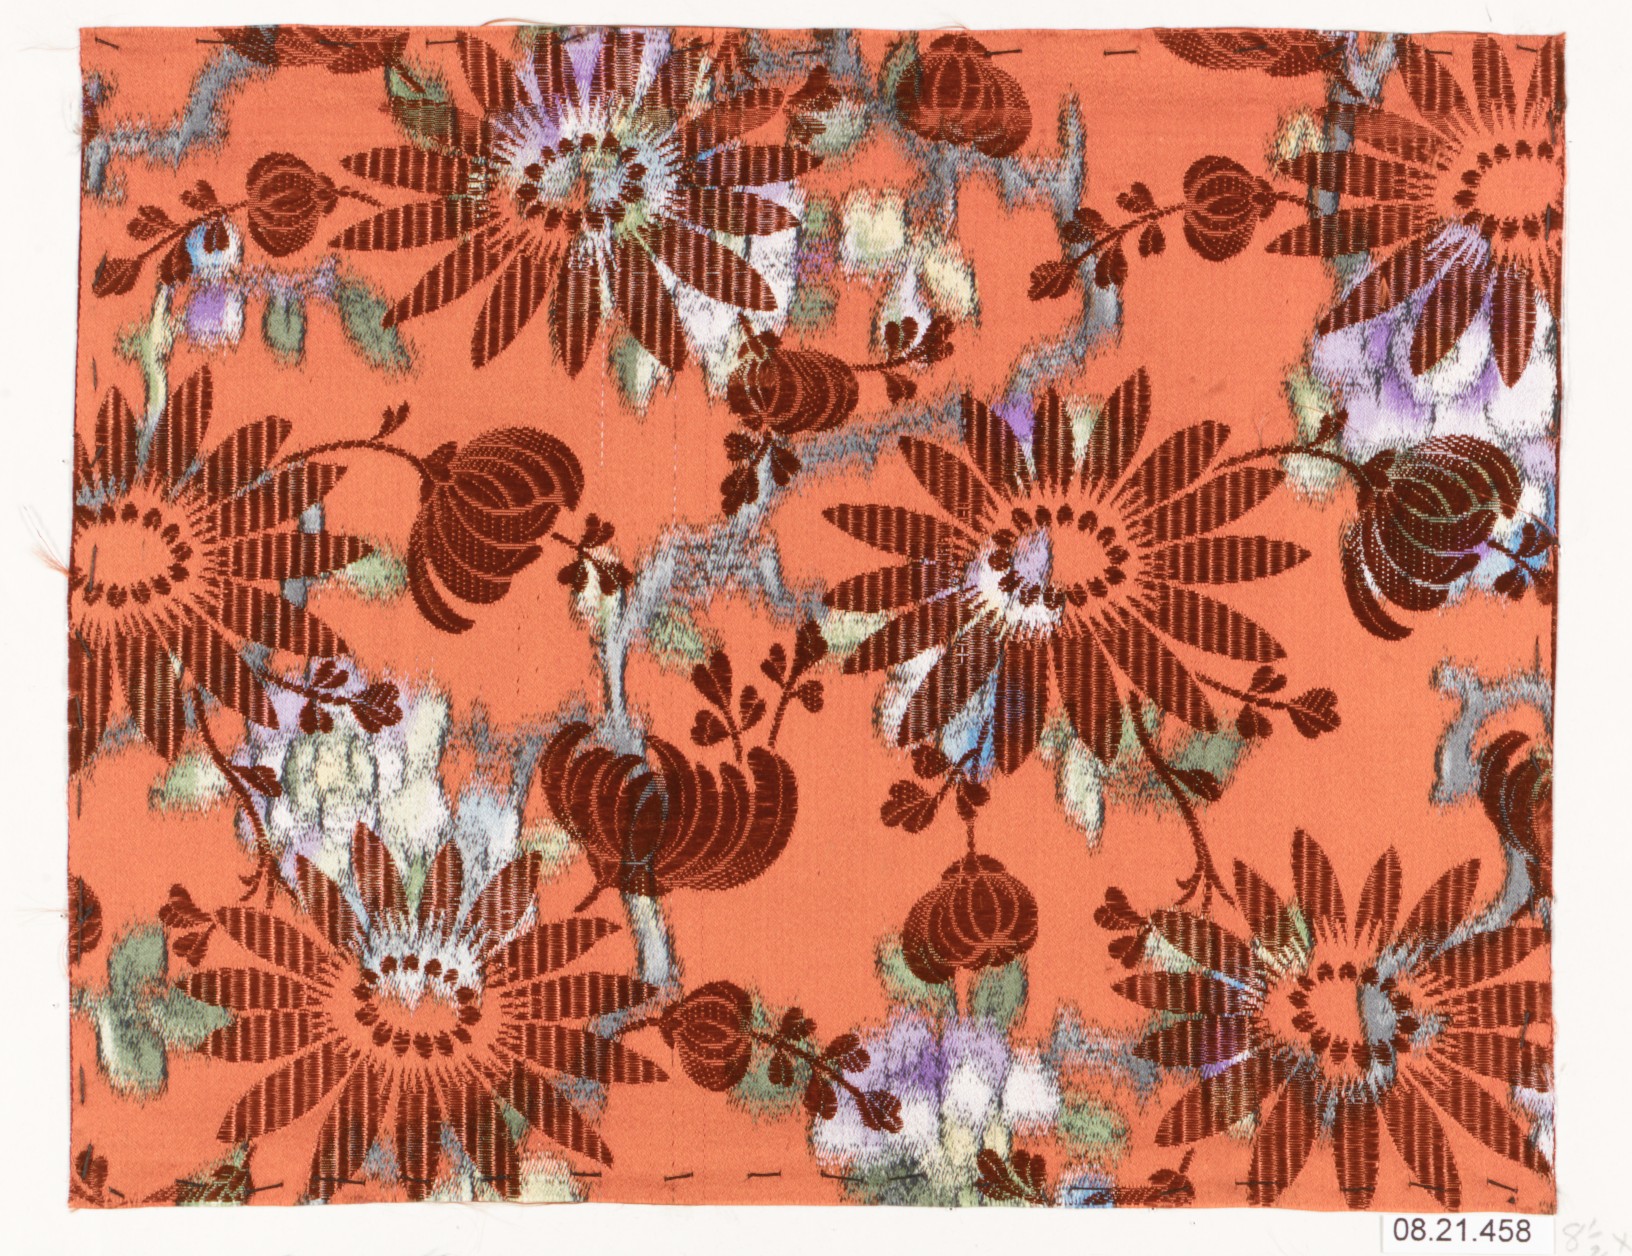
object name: textile sample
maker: Anonymous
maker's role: designer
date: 1900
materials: silk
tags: flowers